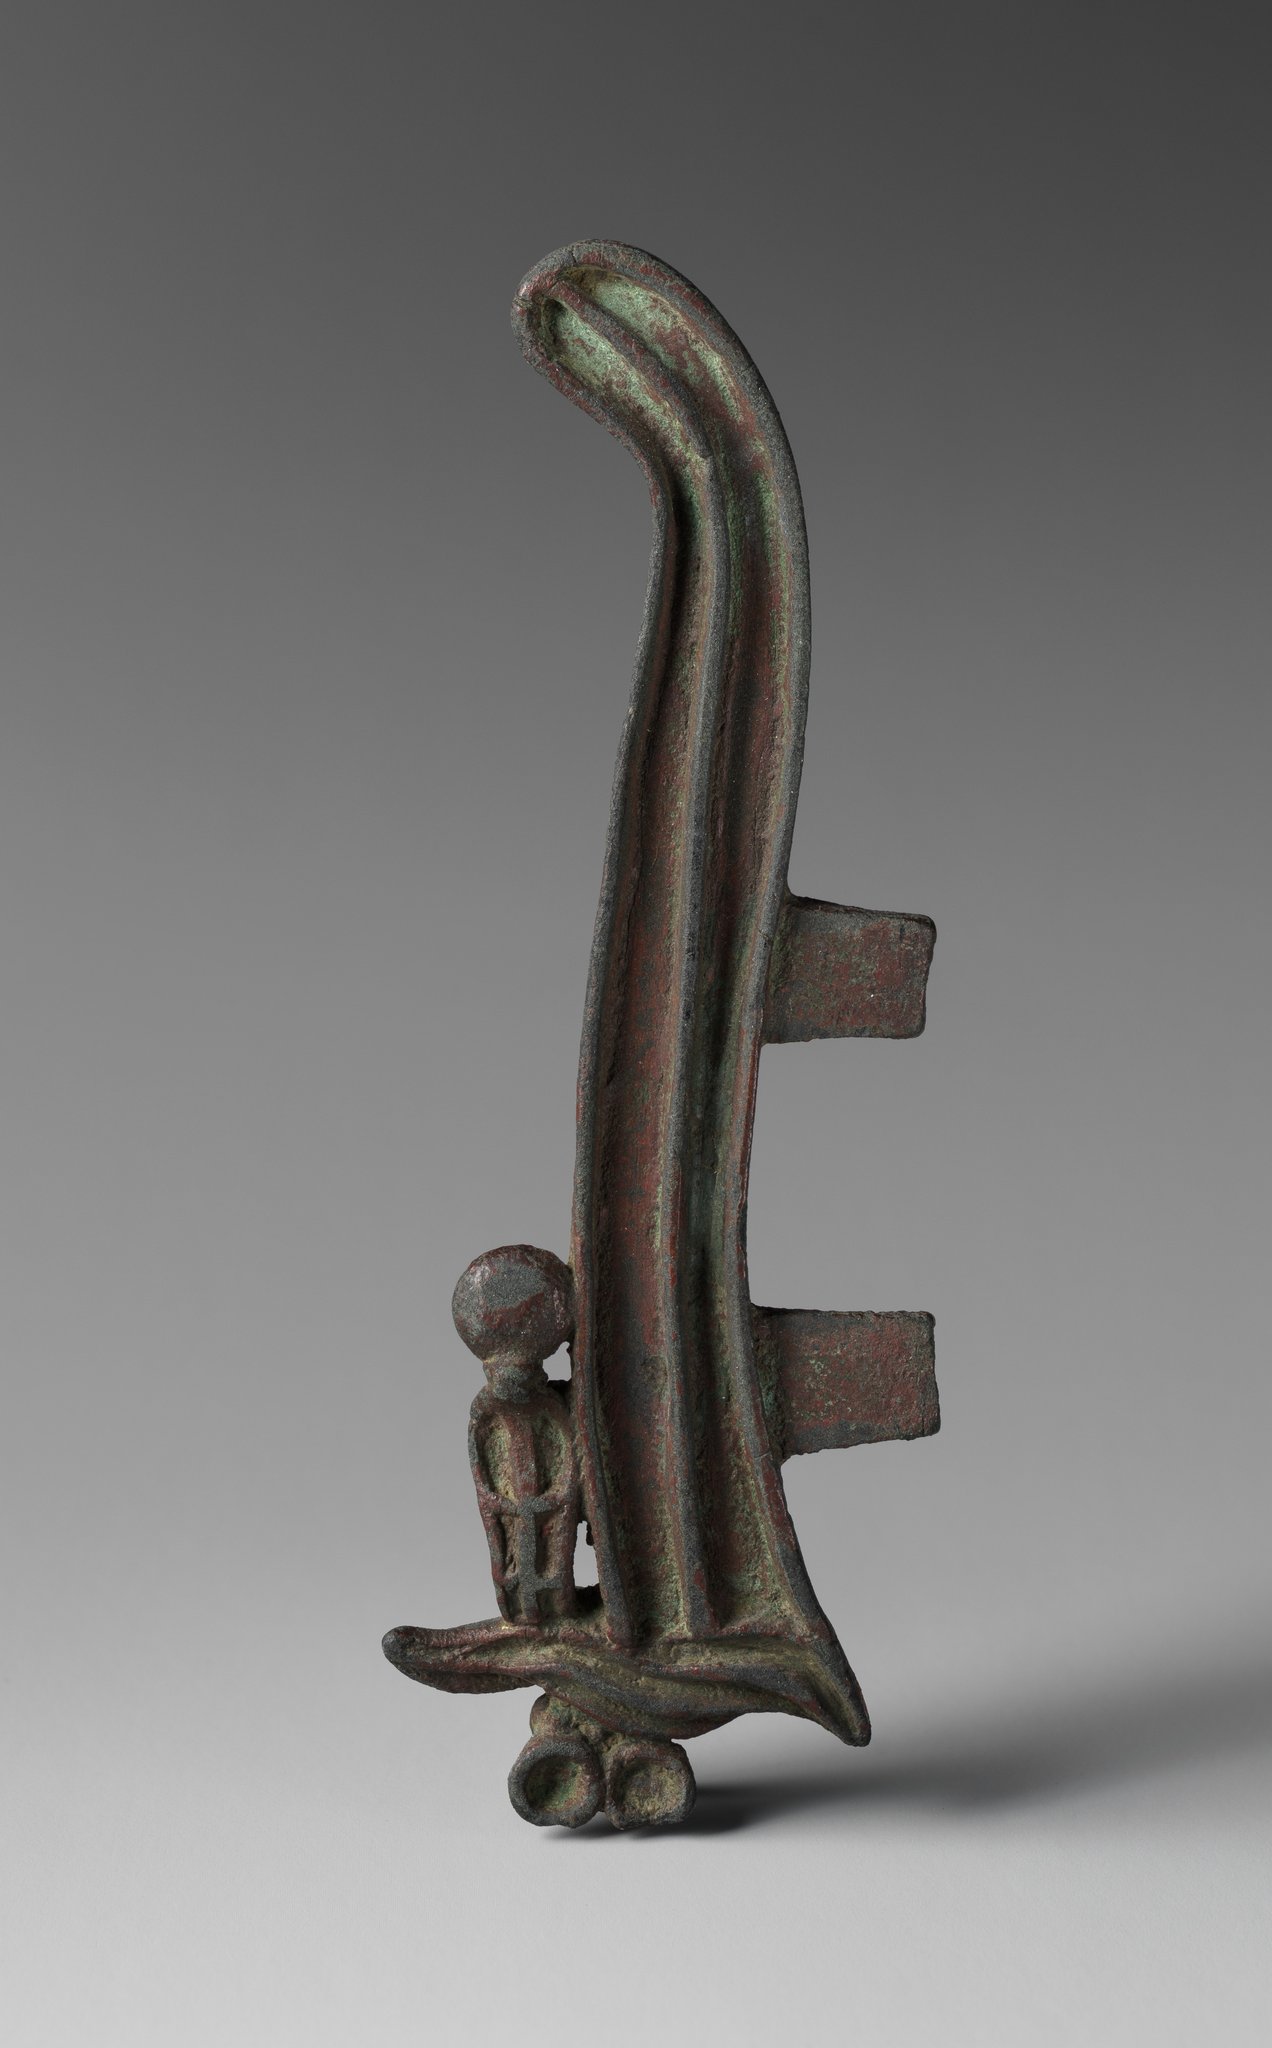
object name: headdress attachment, feather, osiris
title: Attachment for the crown of an Osiris statue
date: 664-332 BCE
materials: bronze, copper alloy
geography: egypt